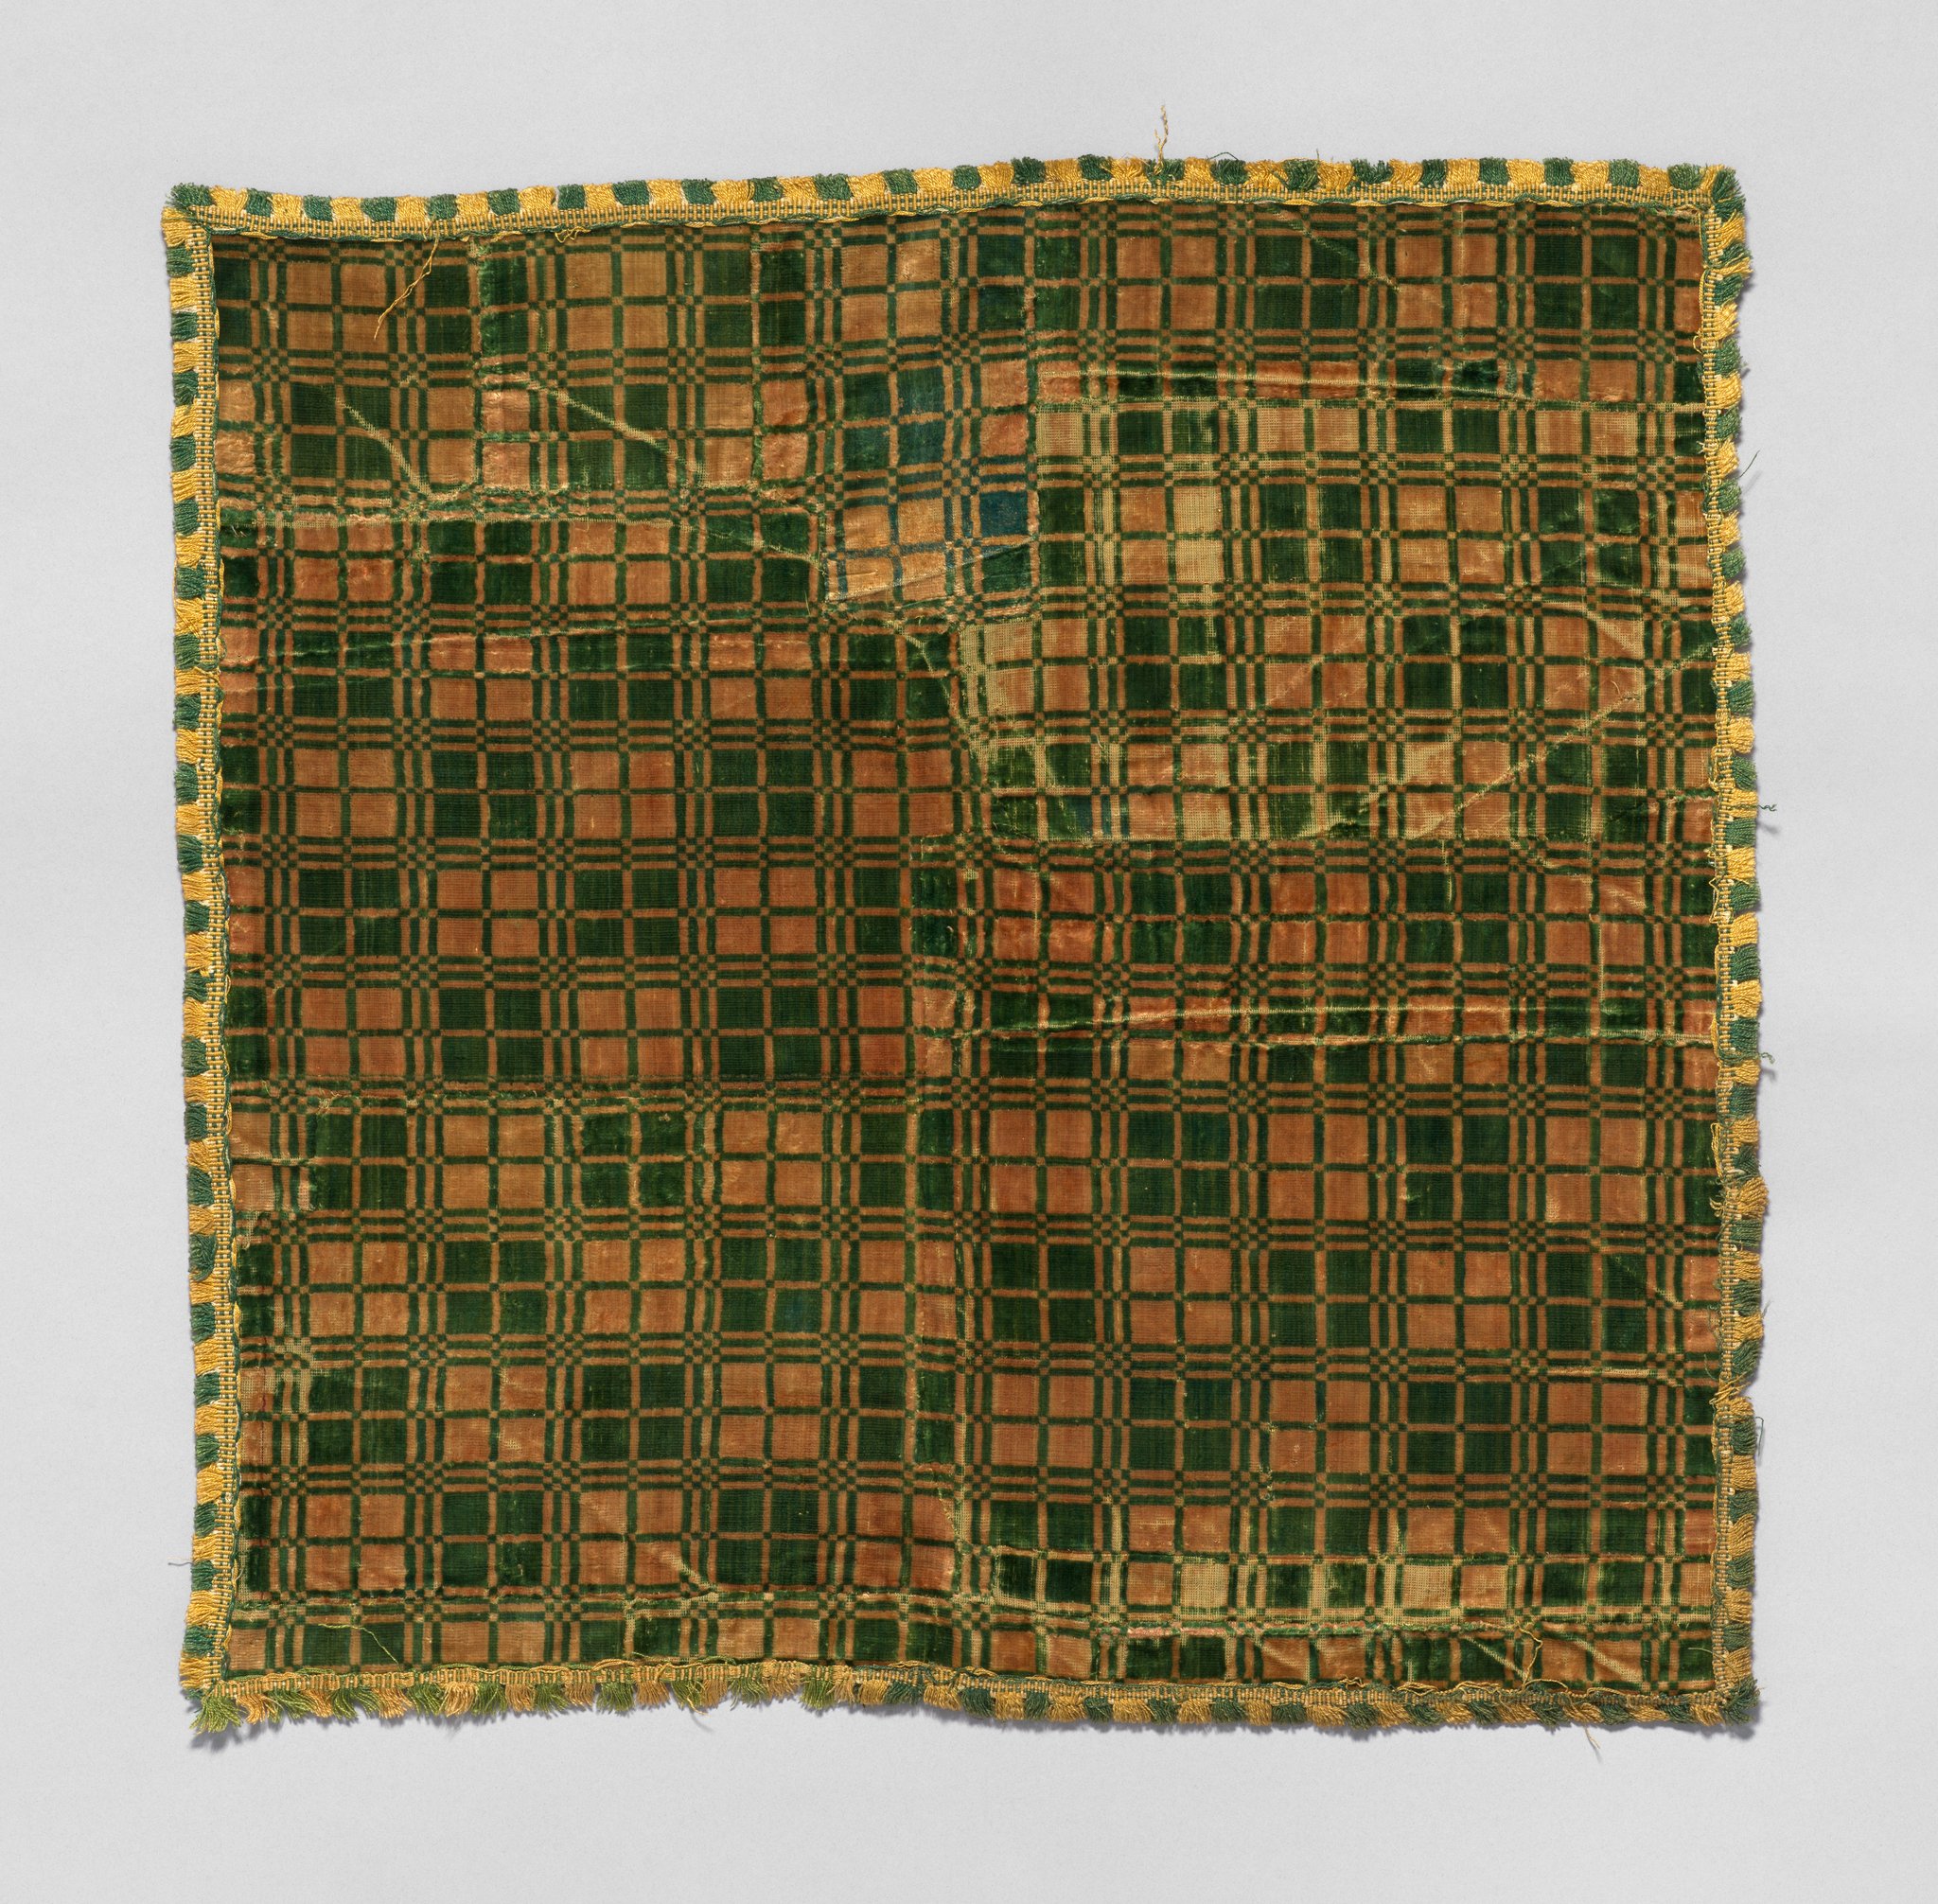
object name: piece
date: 1501-1600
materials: silk